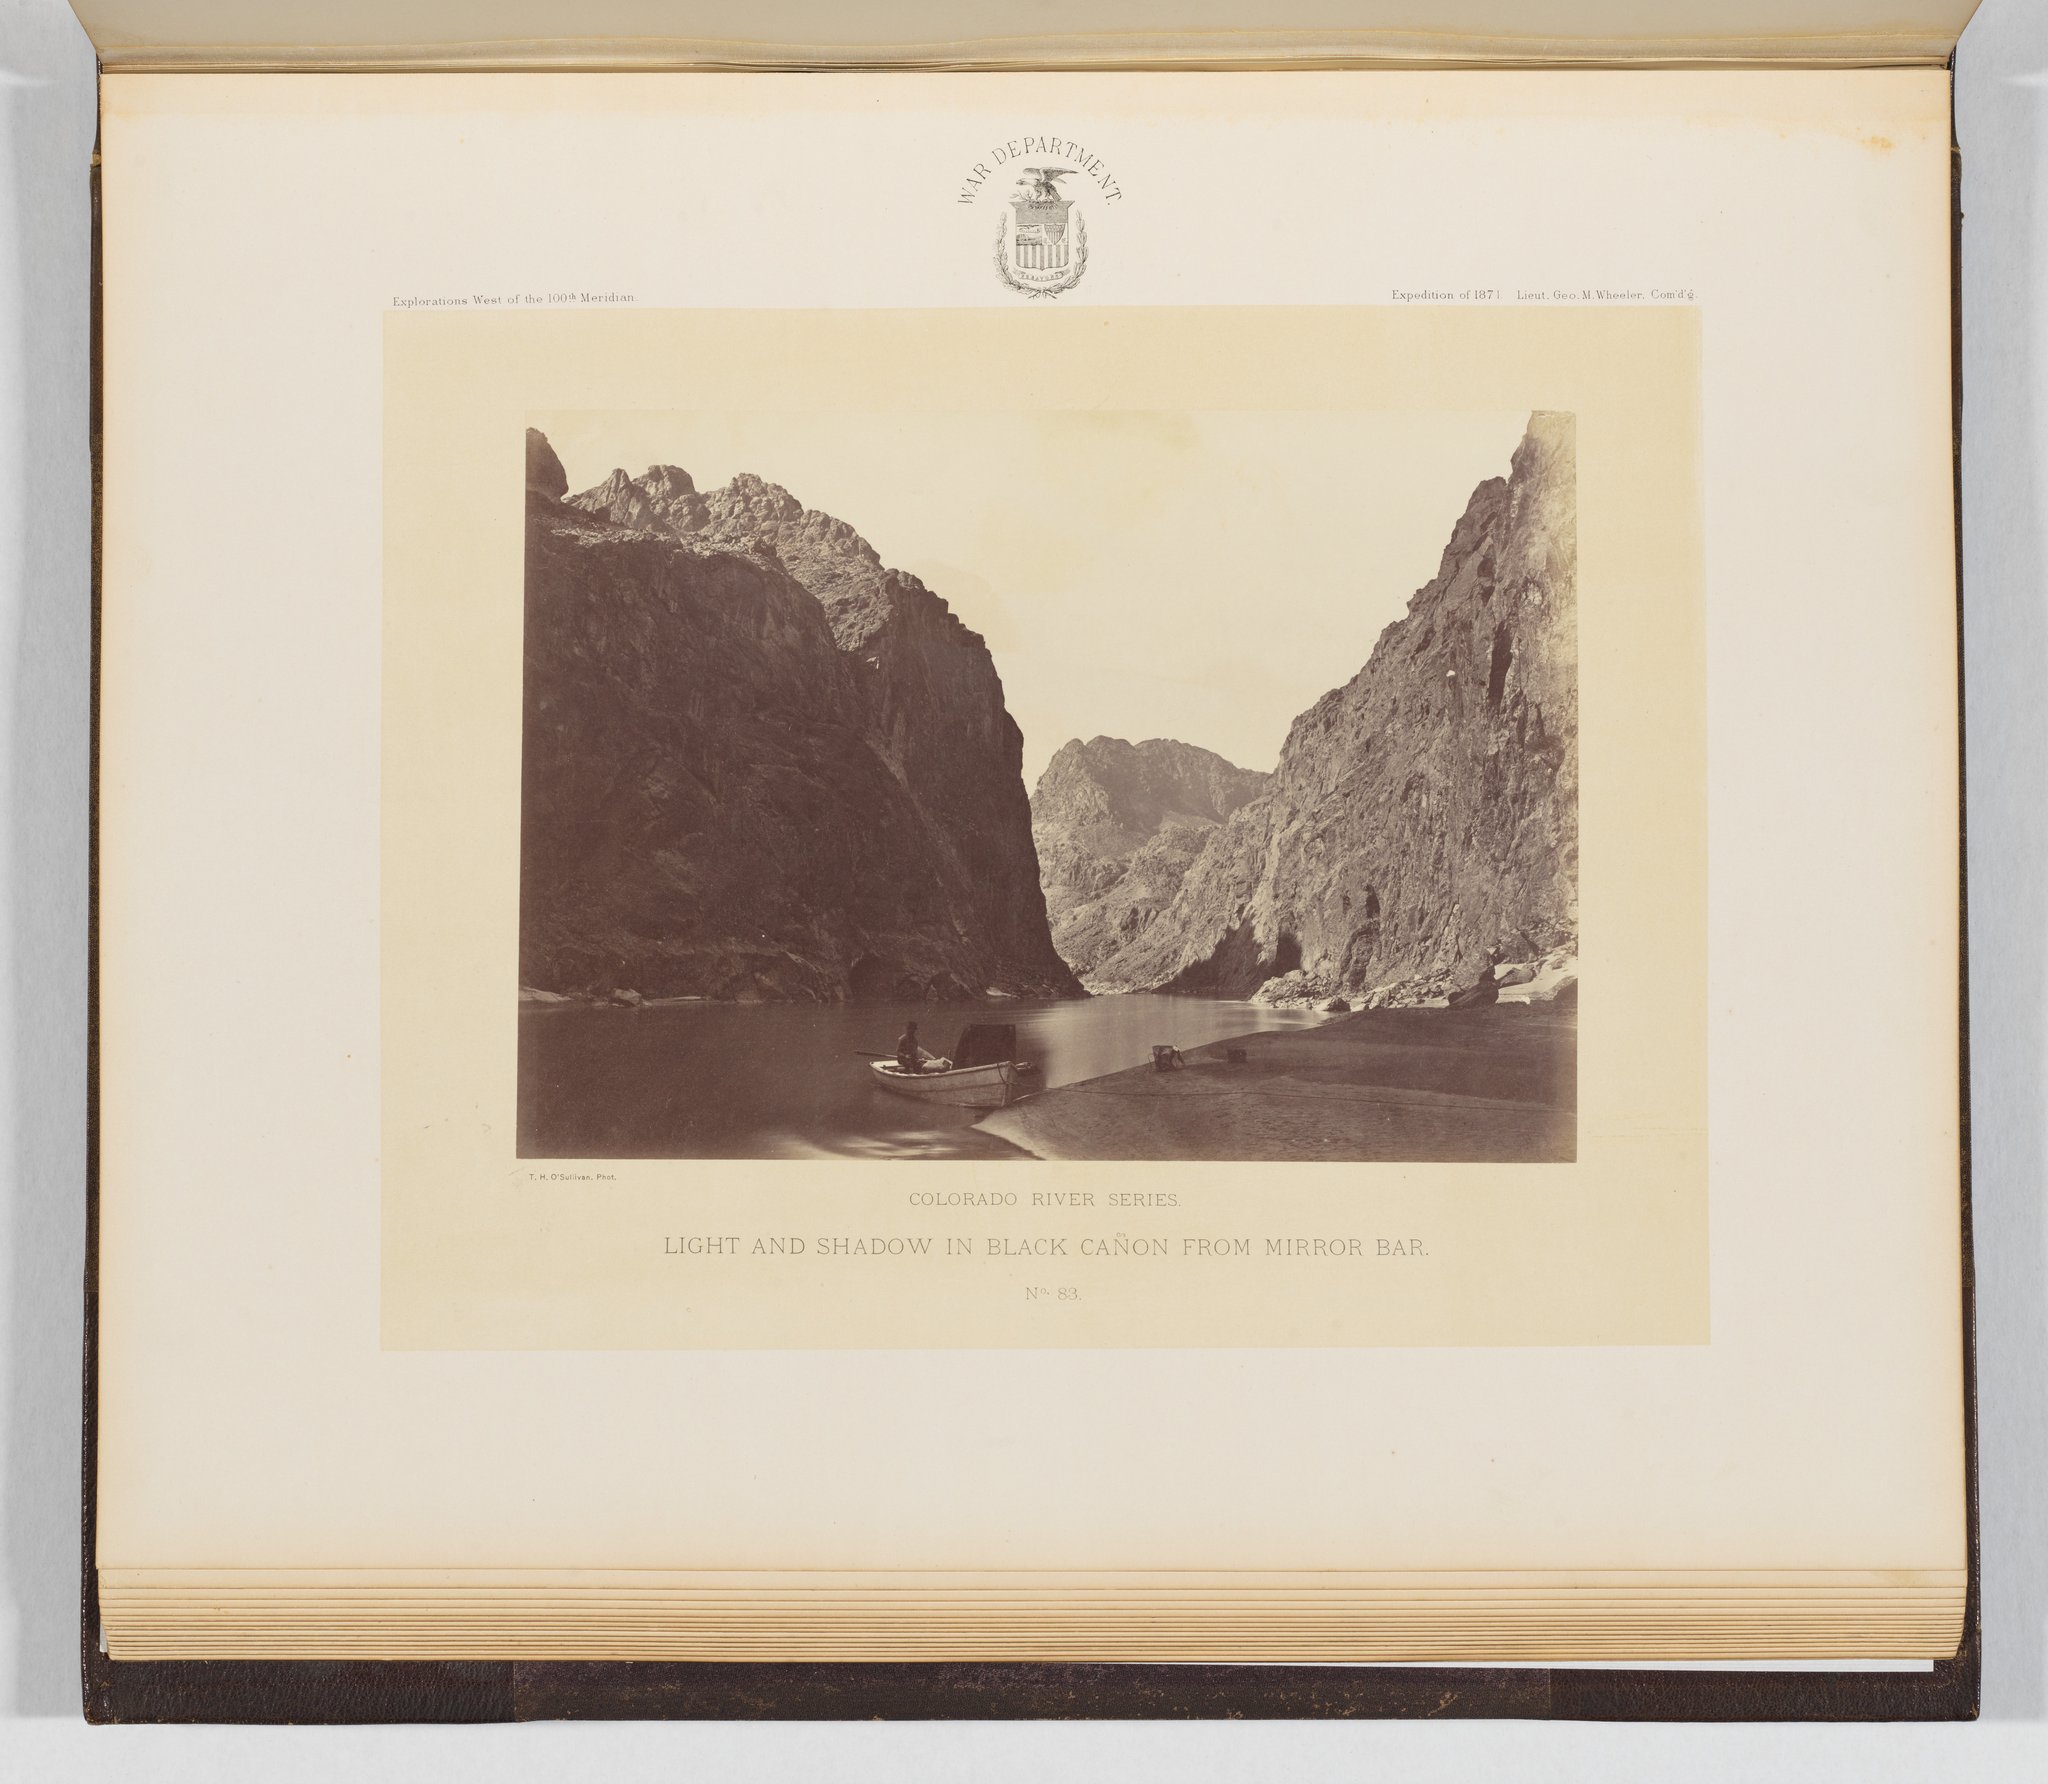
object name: photograph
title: Light and Shadow in Black Cañon, From Mirror Bar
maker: timothy h. o'sullivan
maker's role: artist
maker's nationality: american, born ireland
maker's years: 1840-1882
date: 1871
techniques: albumen silver print, glass negative